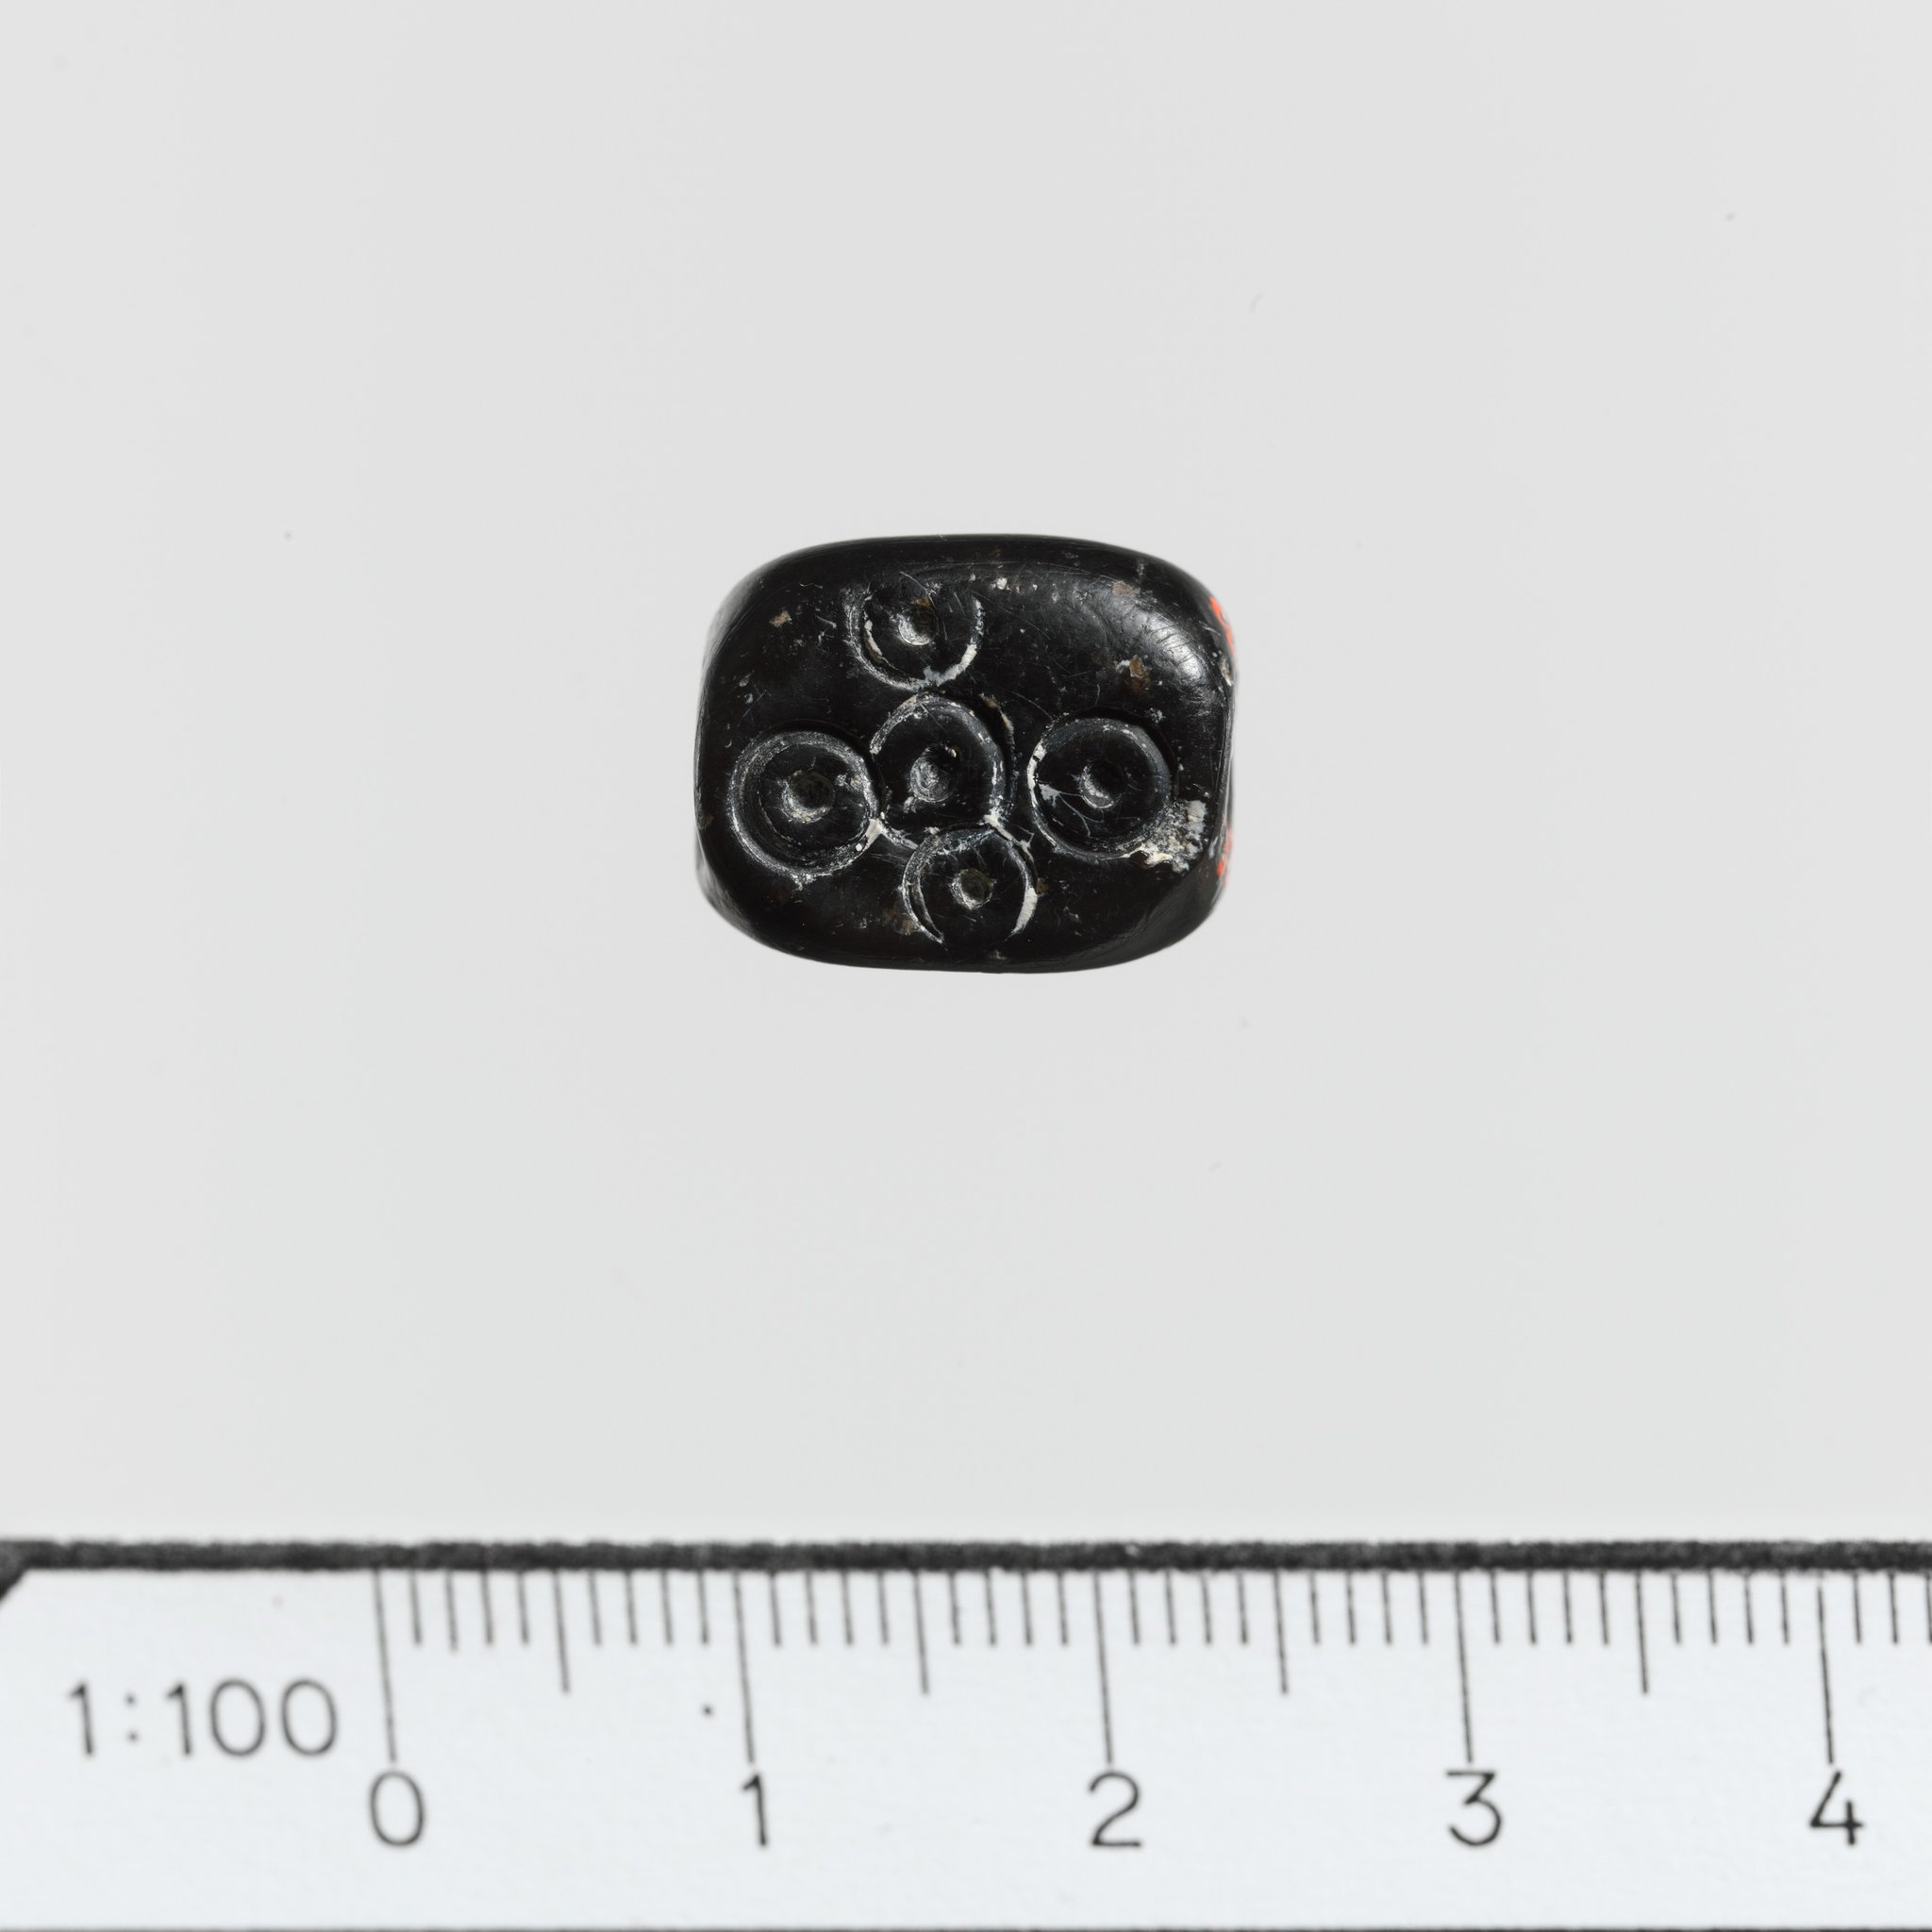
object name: seal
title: Serpentine triangular prism with circles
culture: minoan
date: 2200-2000 BCE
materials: stone